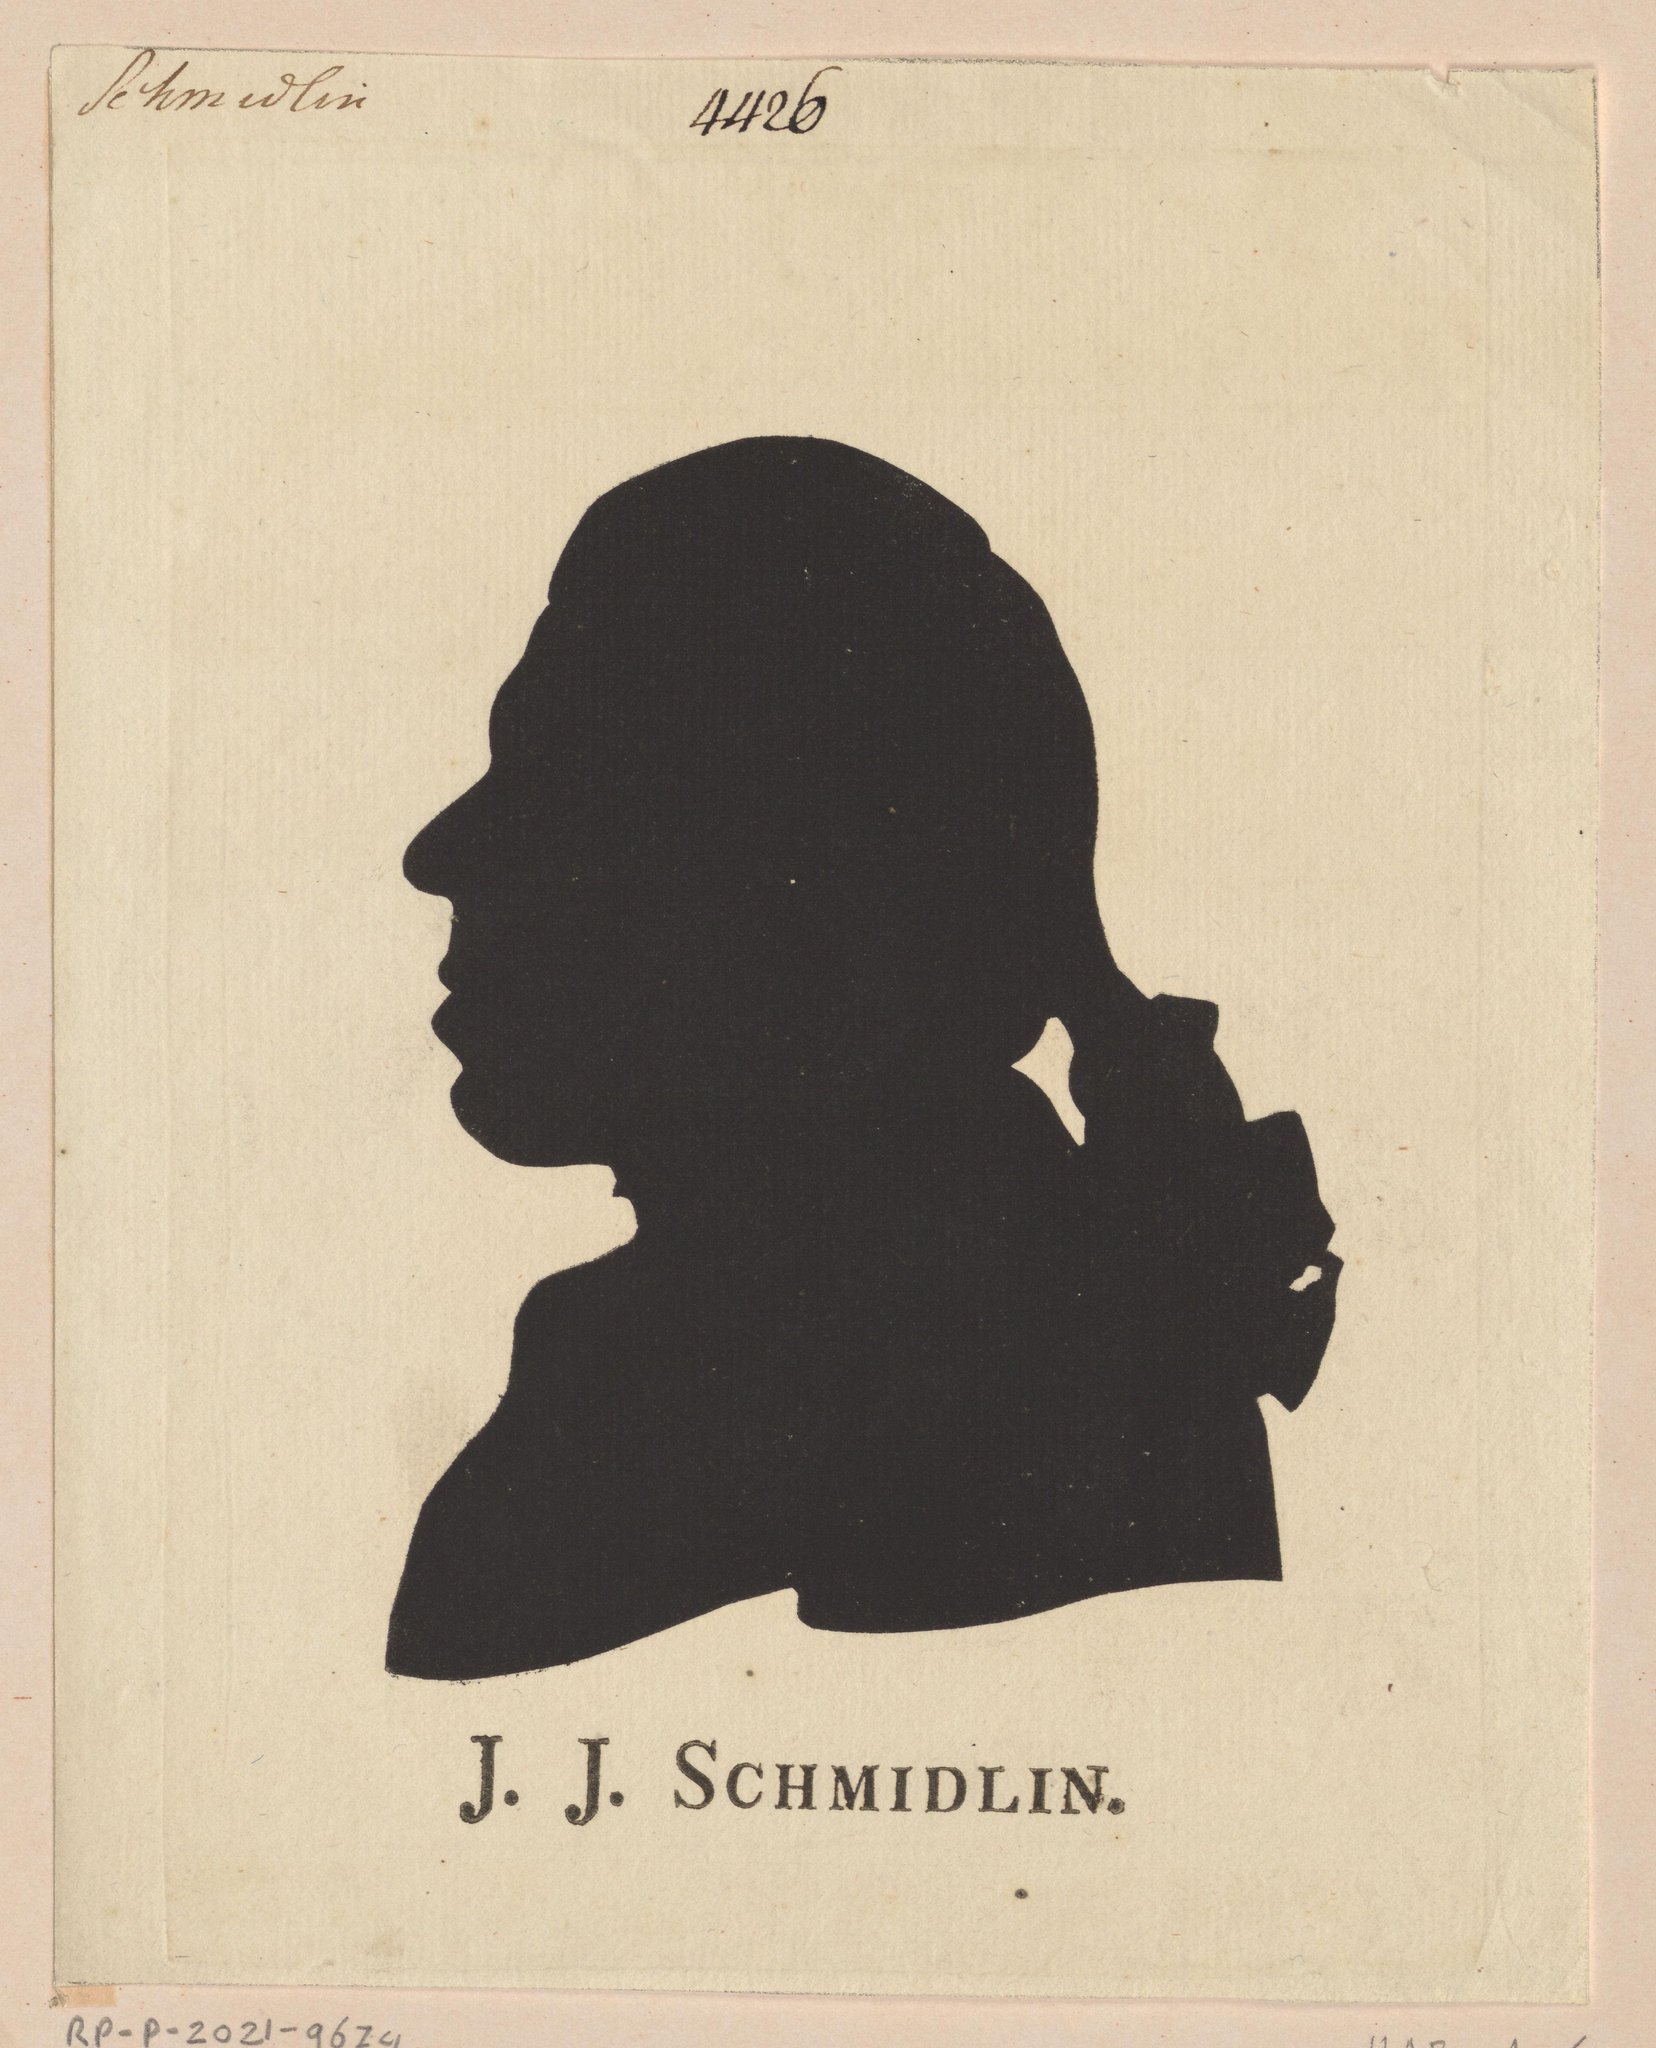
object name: print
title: Silhouetportret van Johann Josef Schmidlin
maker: Anonymous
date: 1750-1799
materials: paper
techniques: blind stamped, letterpress printing, relief print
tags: journalist, reporter, historical persons